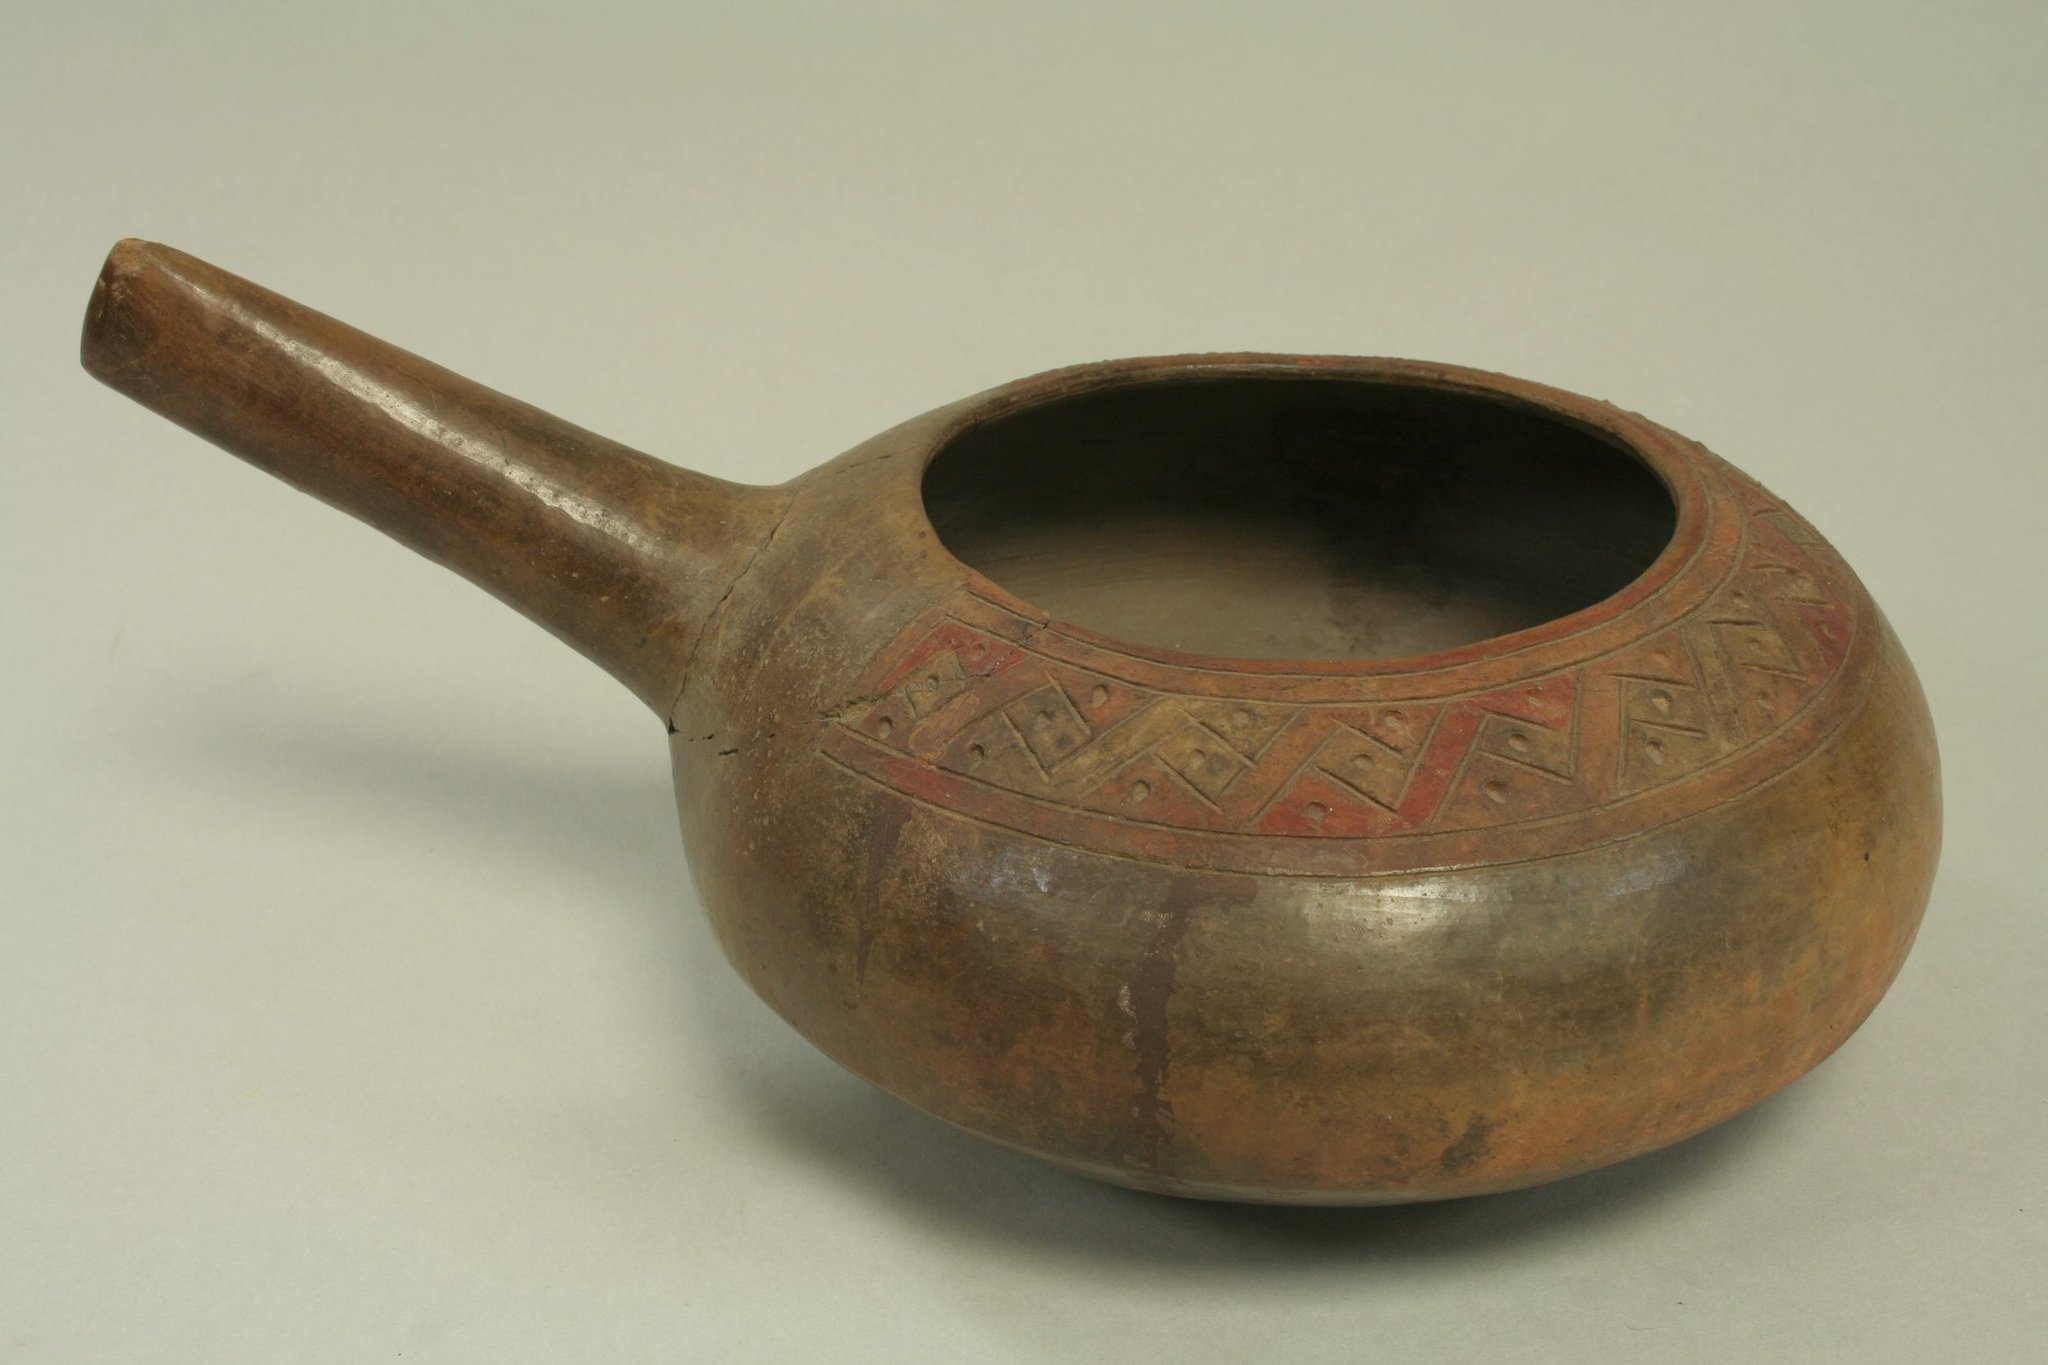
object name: vessel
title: Vessel with Handle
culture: paracas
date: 700-401 BCE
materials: ceramic, pigment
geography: peru